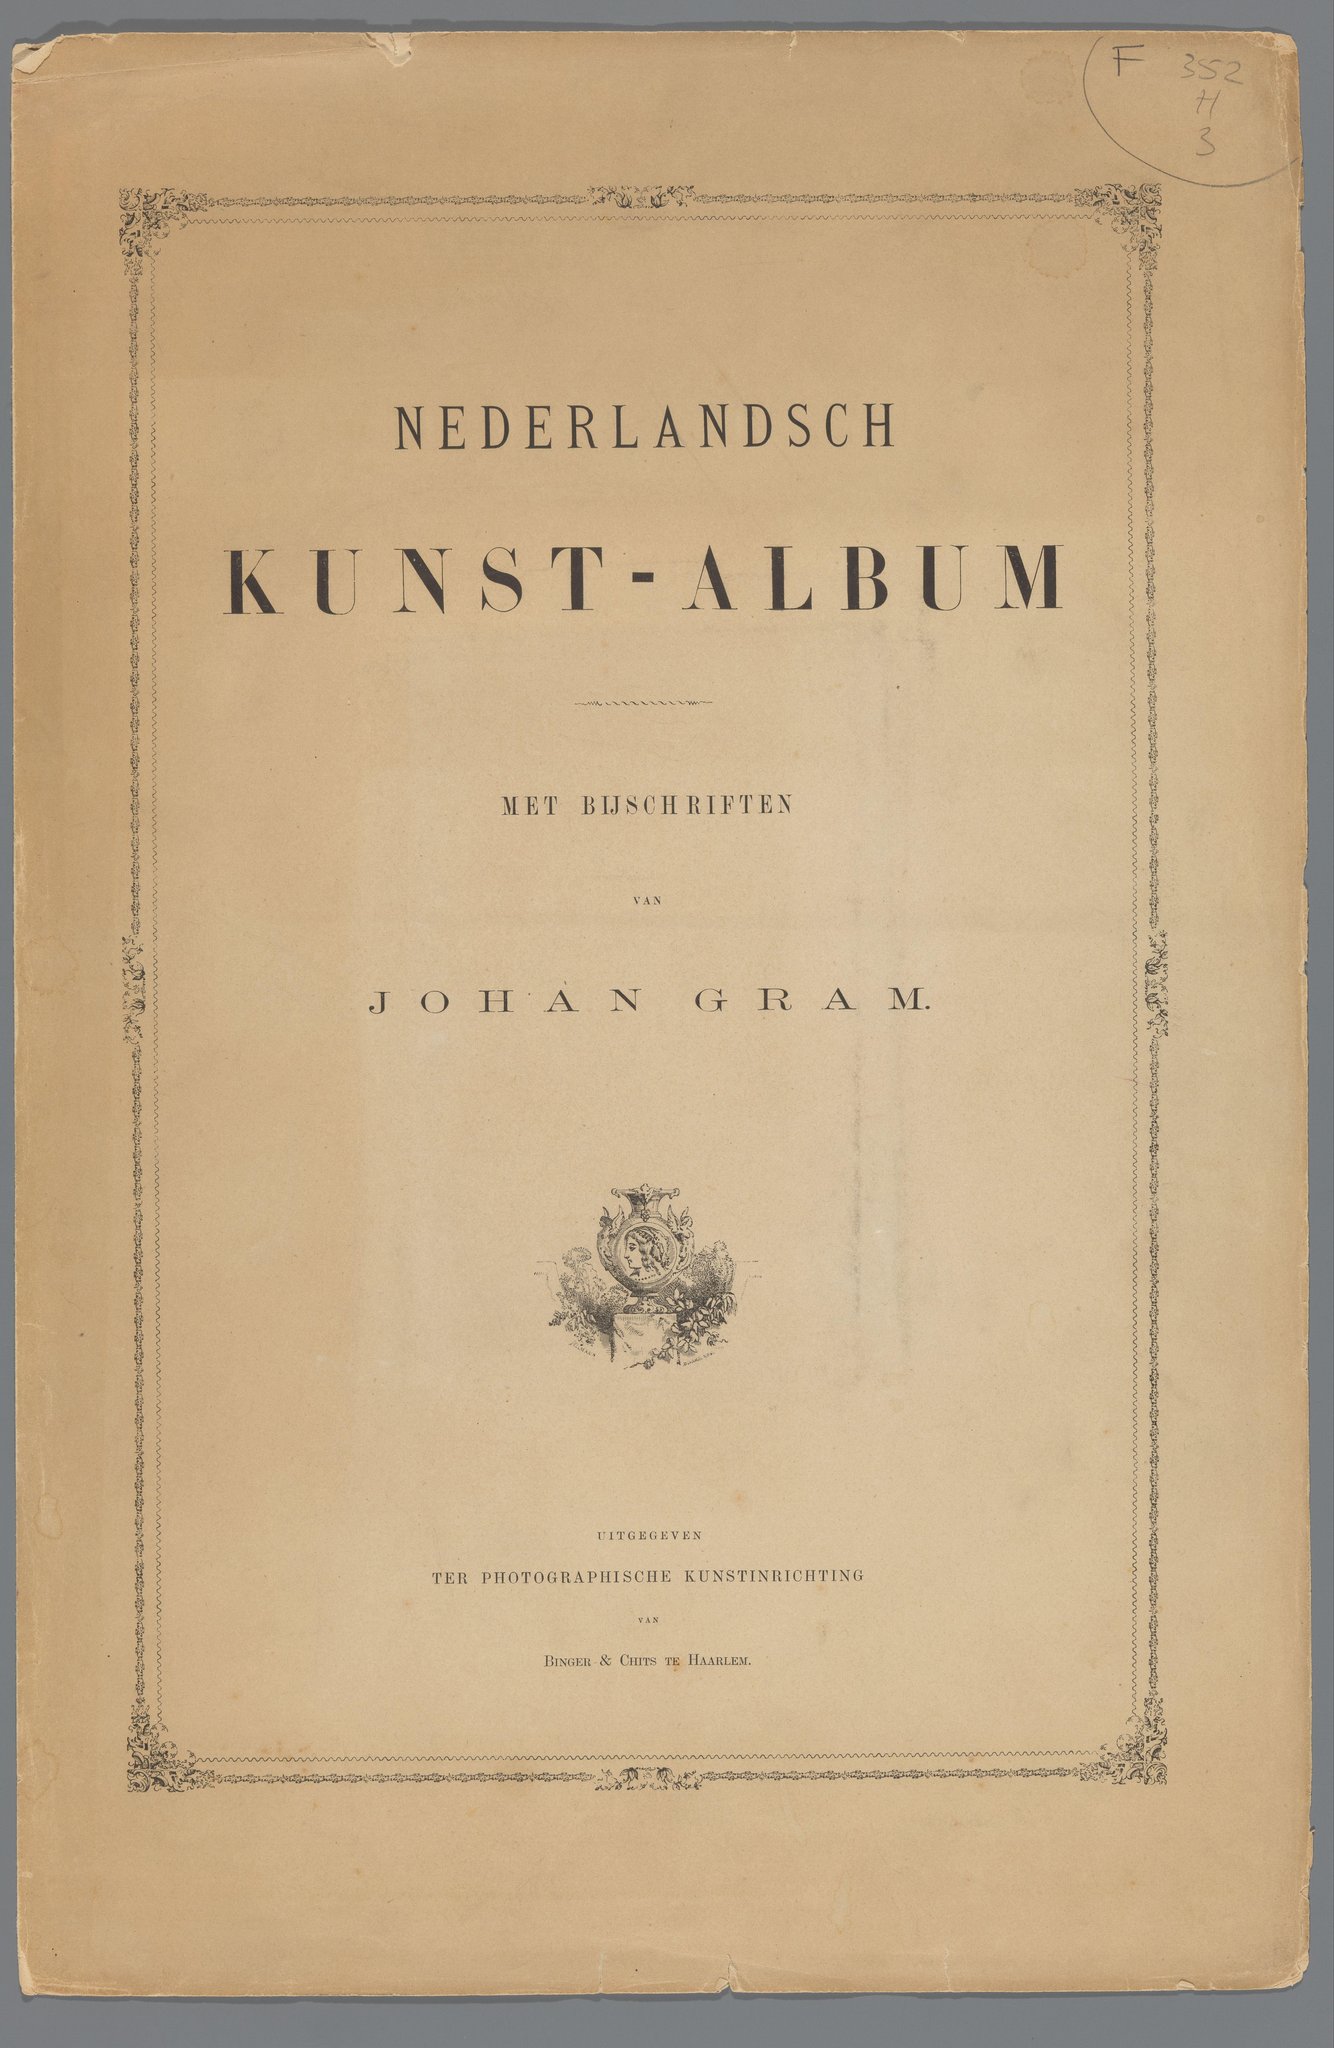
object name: wrapper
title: Nederlandsch kunst-album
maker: johan gram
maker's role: kunstcriticus, letterkundige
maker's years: 1833-1914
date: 1871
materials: cardboard, paper, textile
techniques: printing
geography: haarlem